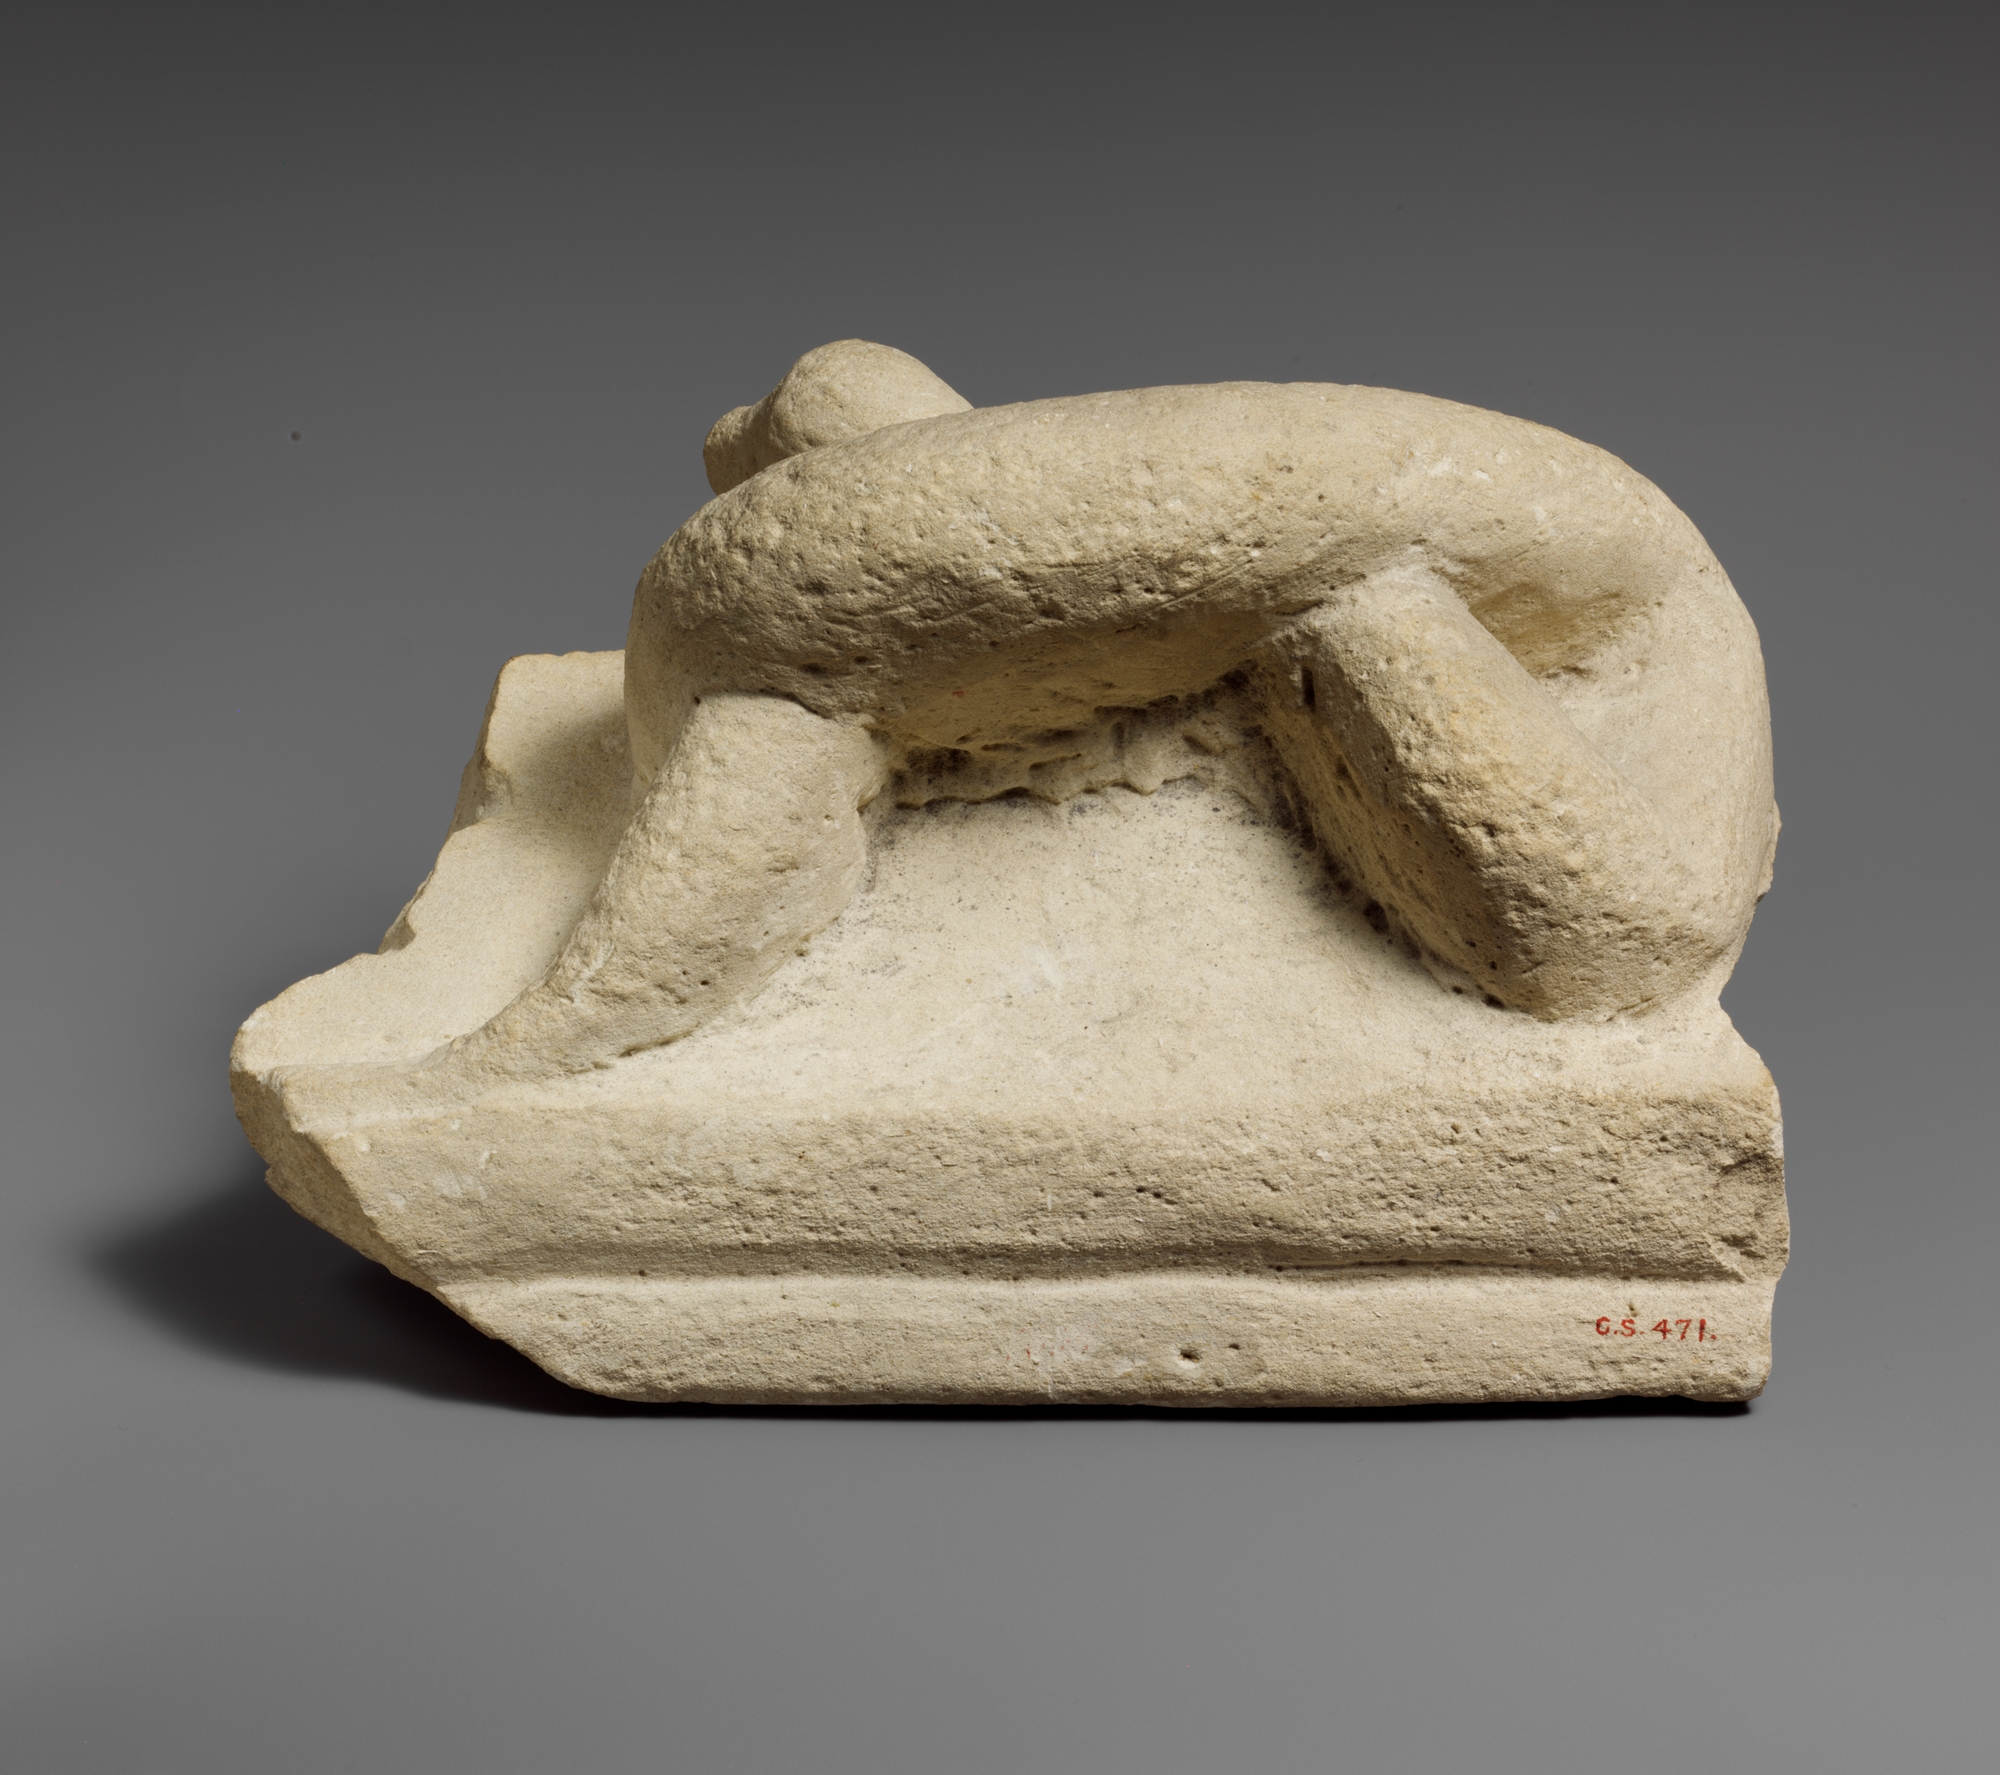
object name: statuette of a snake, coiled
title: Two fragments of a limestone sarcophagus lid with snakes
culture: cypriot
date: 500-451 BCE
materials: limestone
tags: snakes,sarcophagus